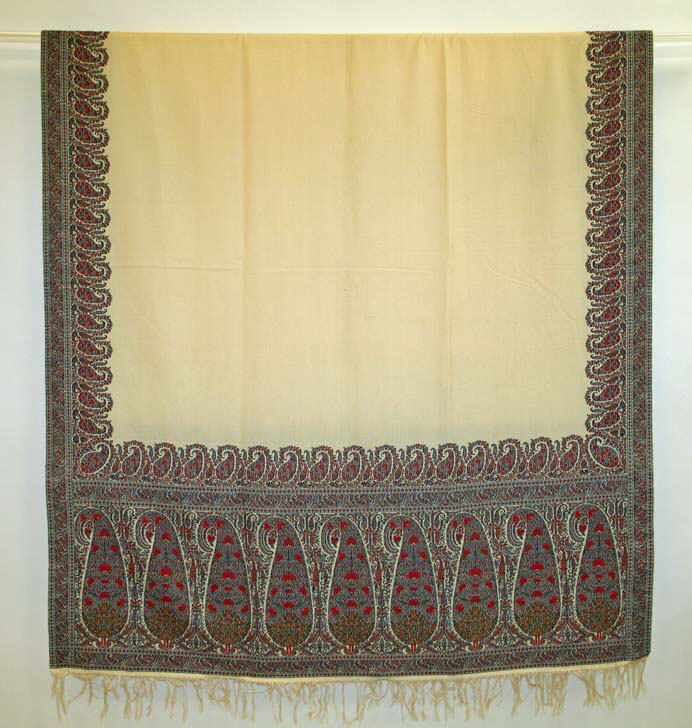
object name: shawl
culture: british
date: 1820-1830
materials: silk, wool